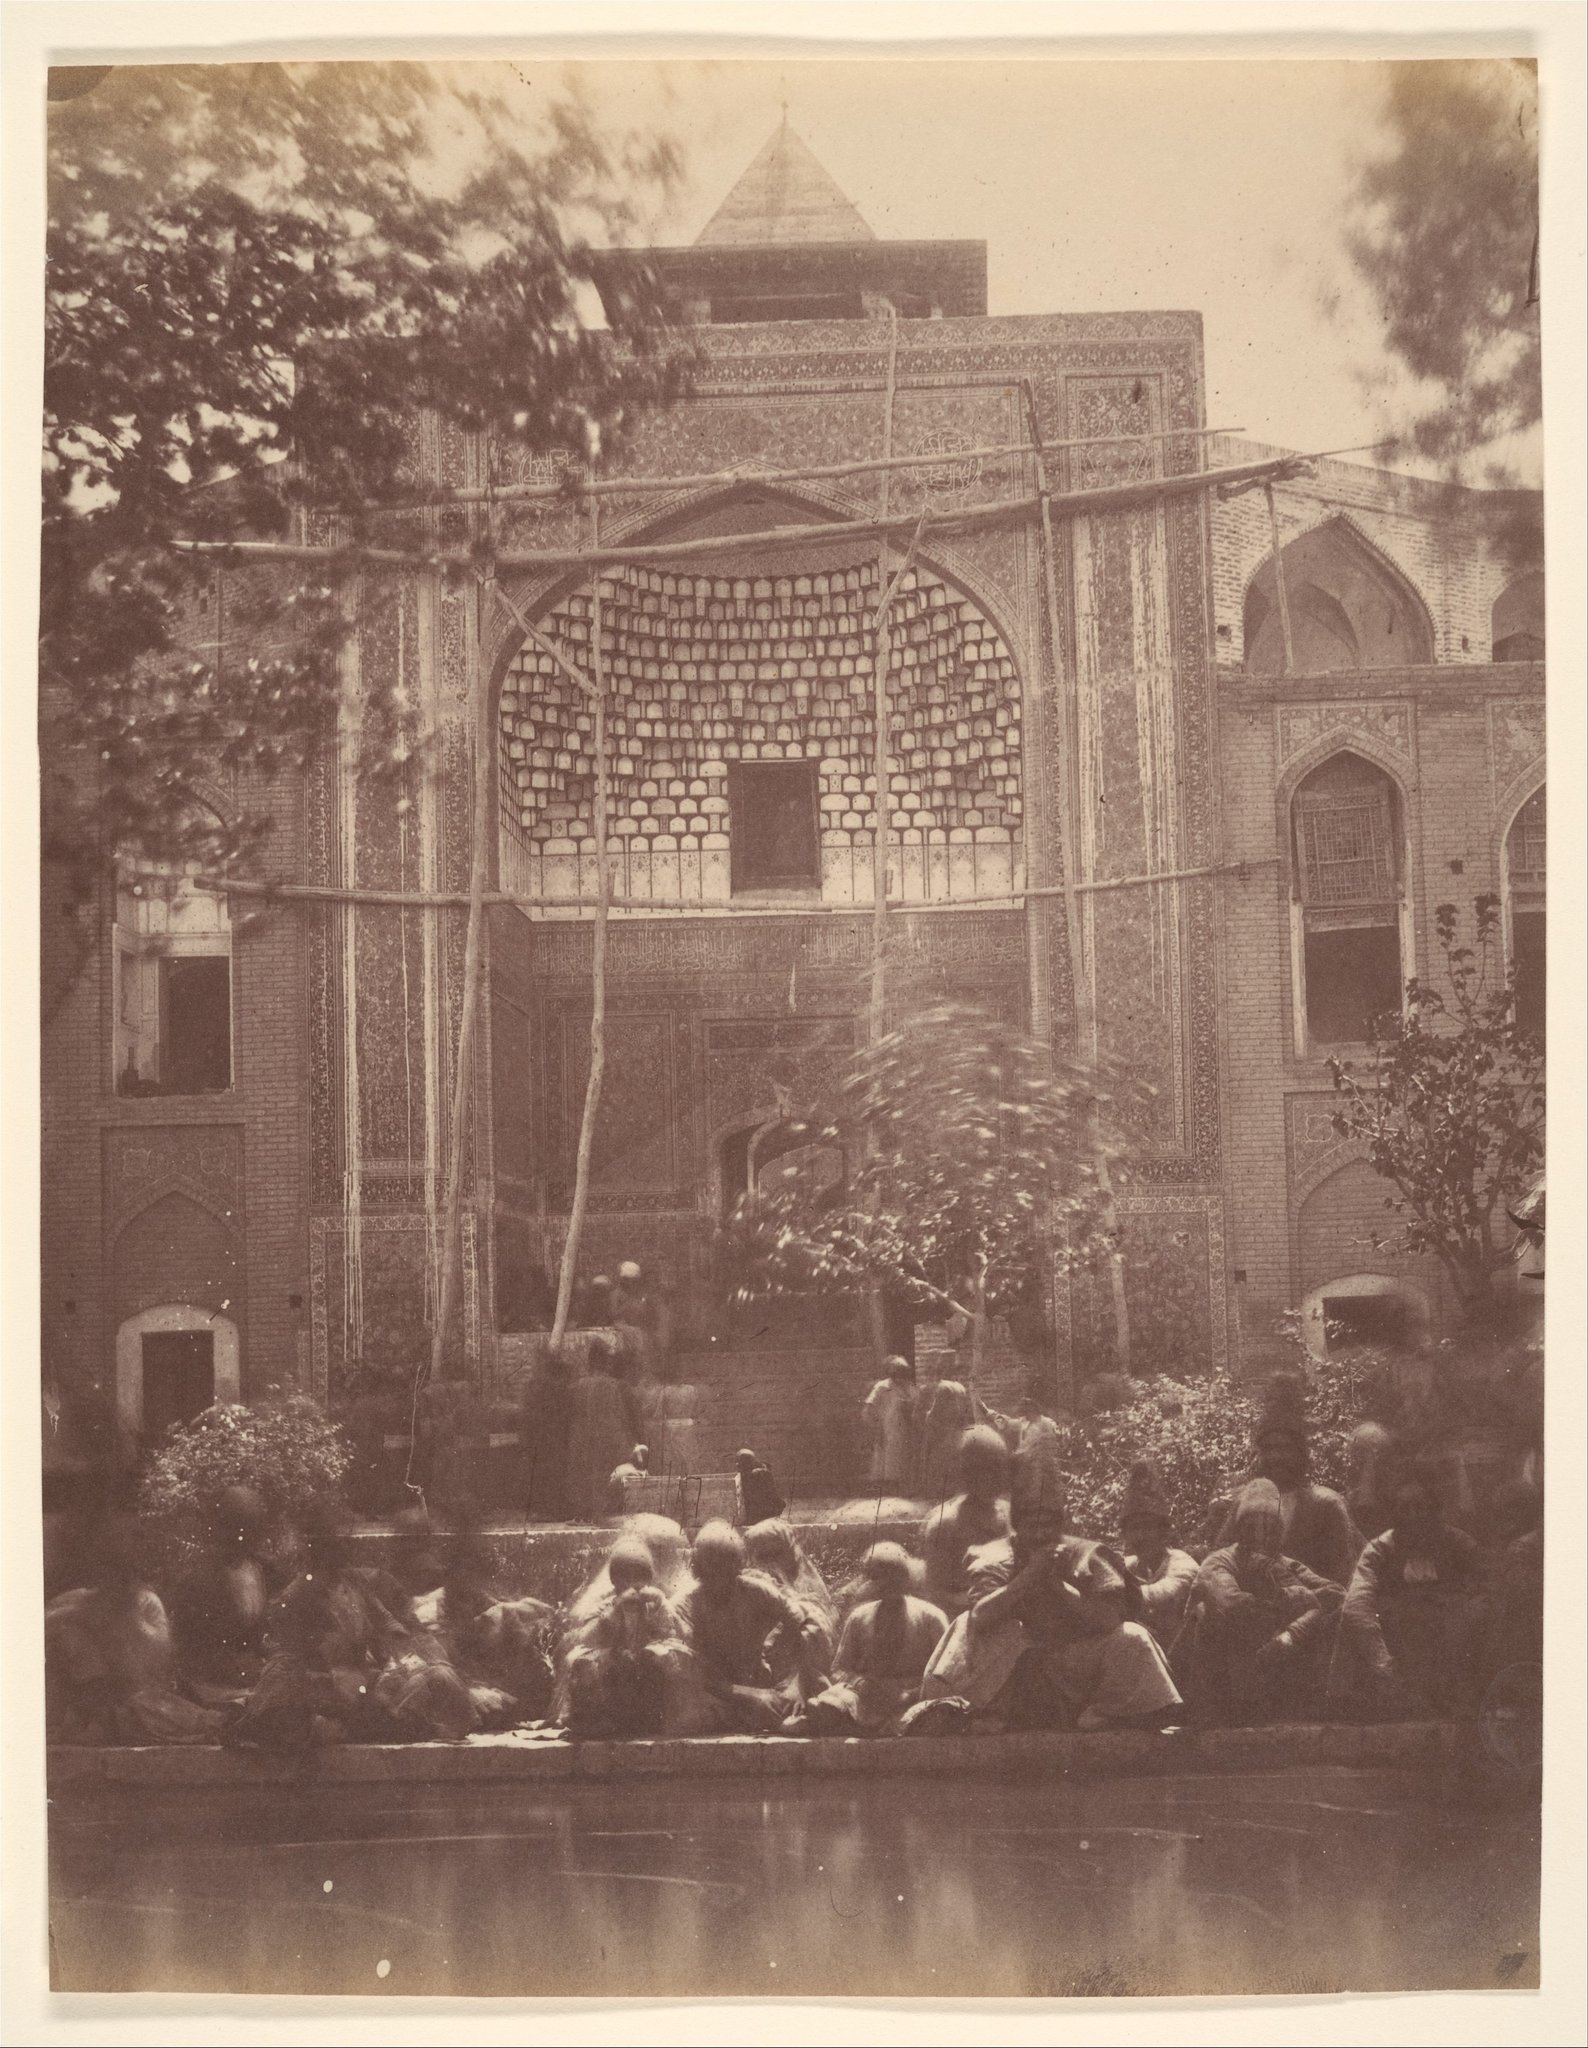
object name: photograph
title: [Mosque of Koum]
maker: luigi pesce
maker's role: artist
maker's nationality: italian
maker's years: 1818-1891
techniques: albumen silver print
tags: mosques